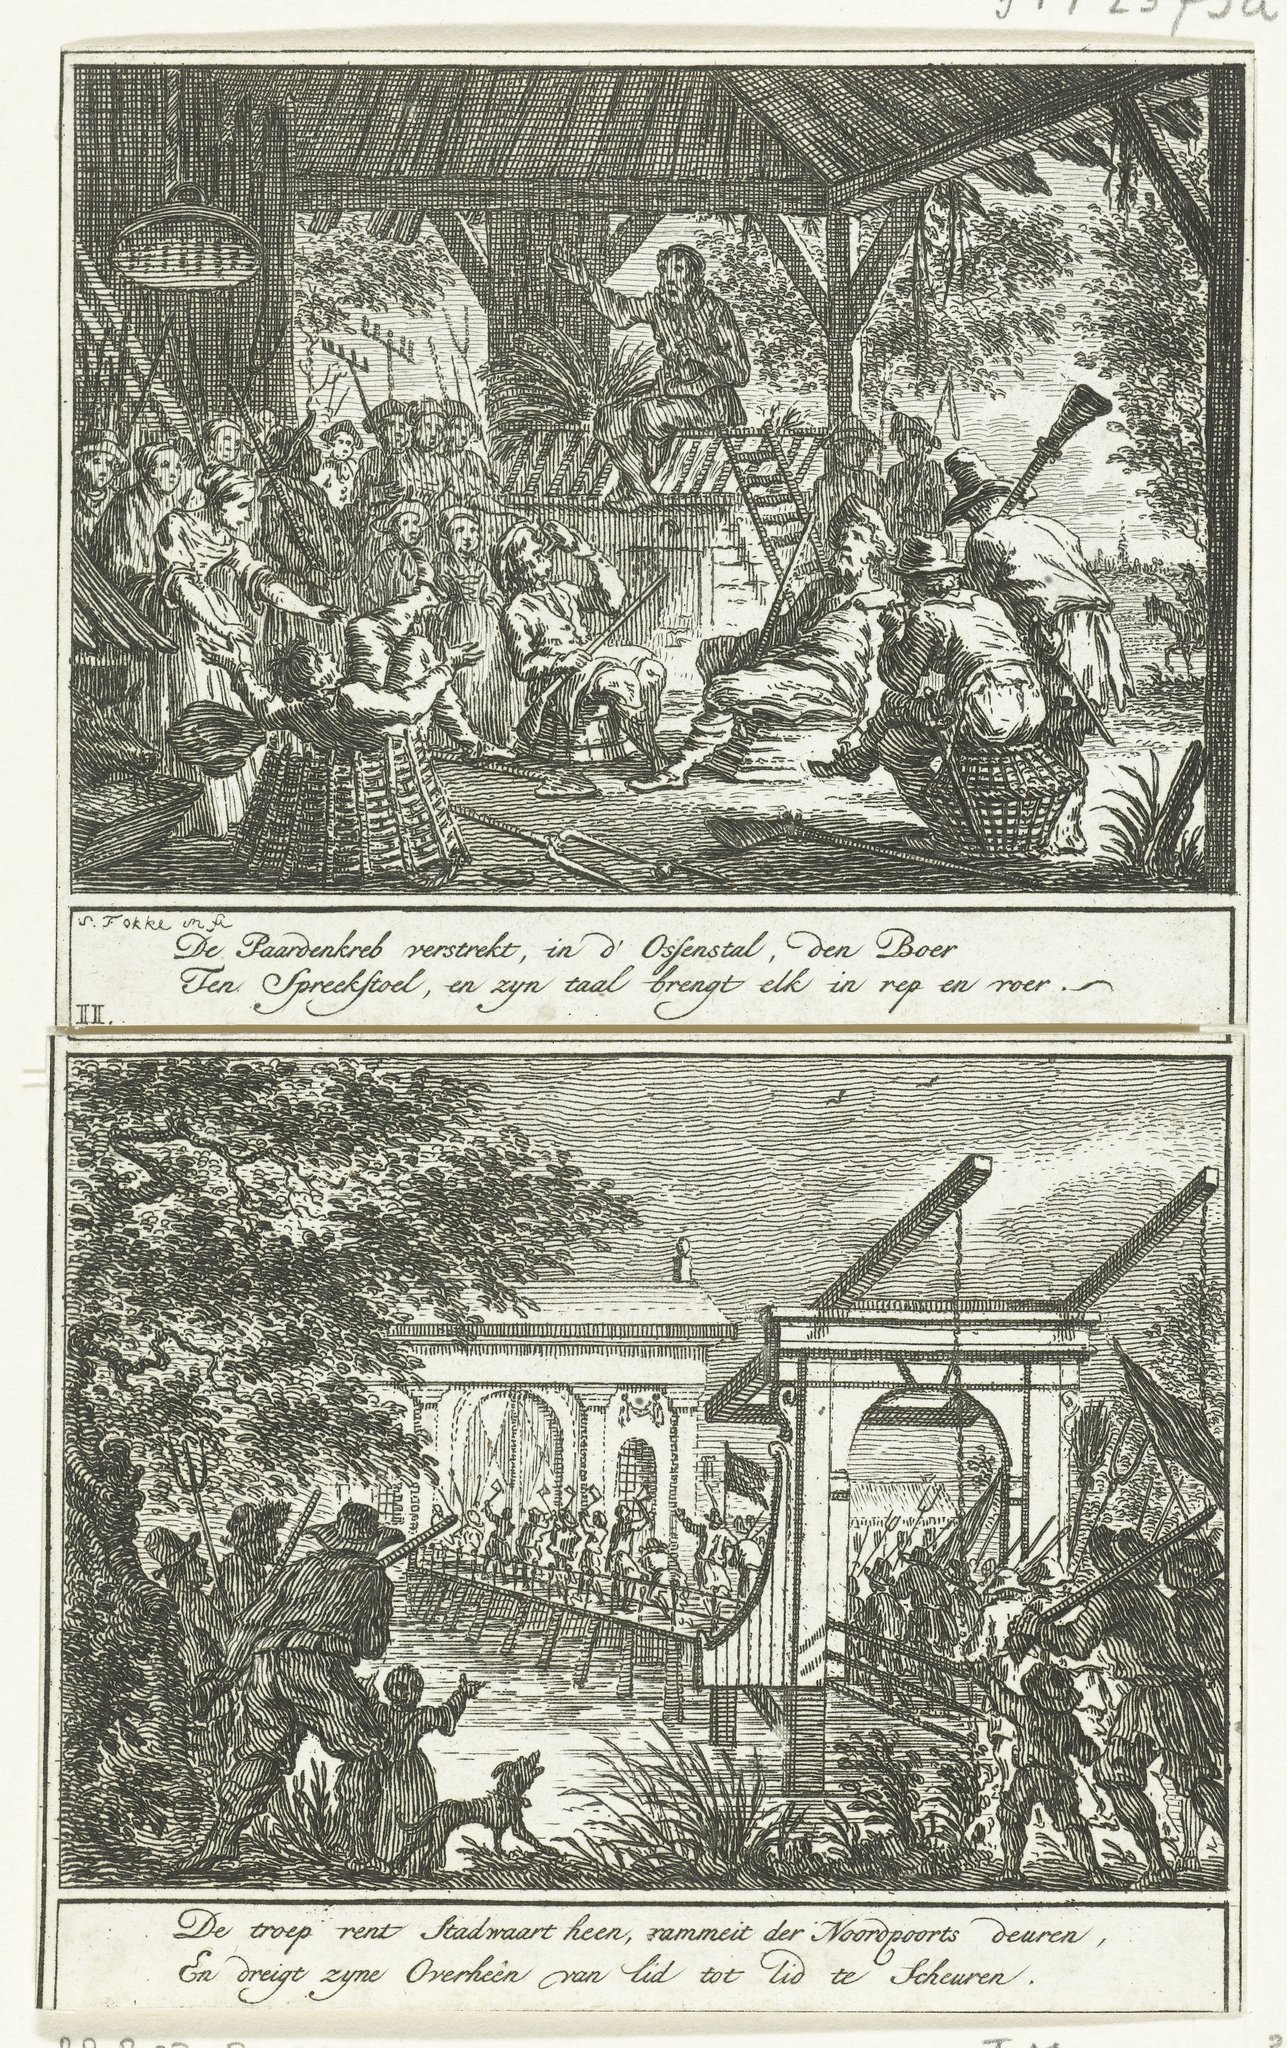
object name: print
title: Bestorming van de Noordpoort te Middelburg, 1672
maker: simon fokke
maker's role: draughtsman, print maker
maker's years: 1712-1784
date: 1764-1766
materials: paper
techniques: etching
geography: northern netherlands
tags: mayor, middelburg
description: Bestorming van de Noordpoort te Middelburg door de opstandige boeren, 1672. Met onderschrift van twee regels. Illustratie nr. III bij een gedicht van Petrus Johannes Beronicius over de opstandige Zeeuwse boeren en het tumult te Middelburg rond burgemeester Filips van den Brande op 21 juli 1672.